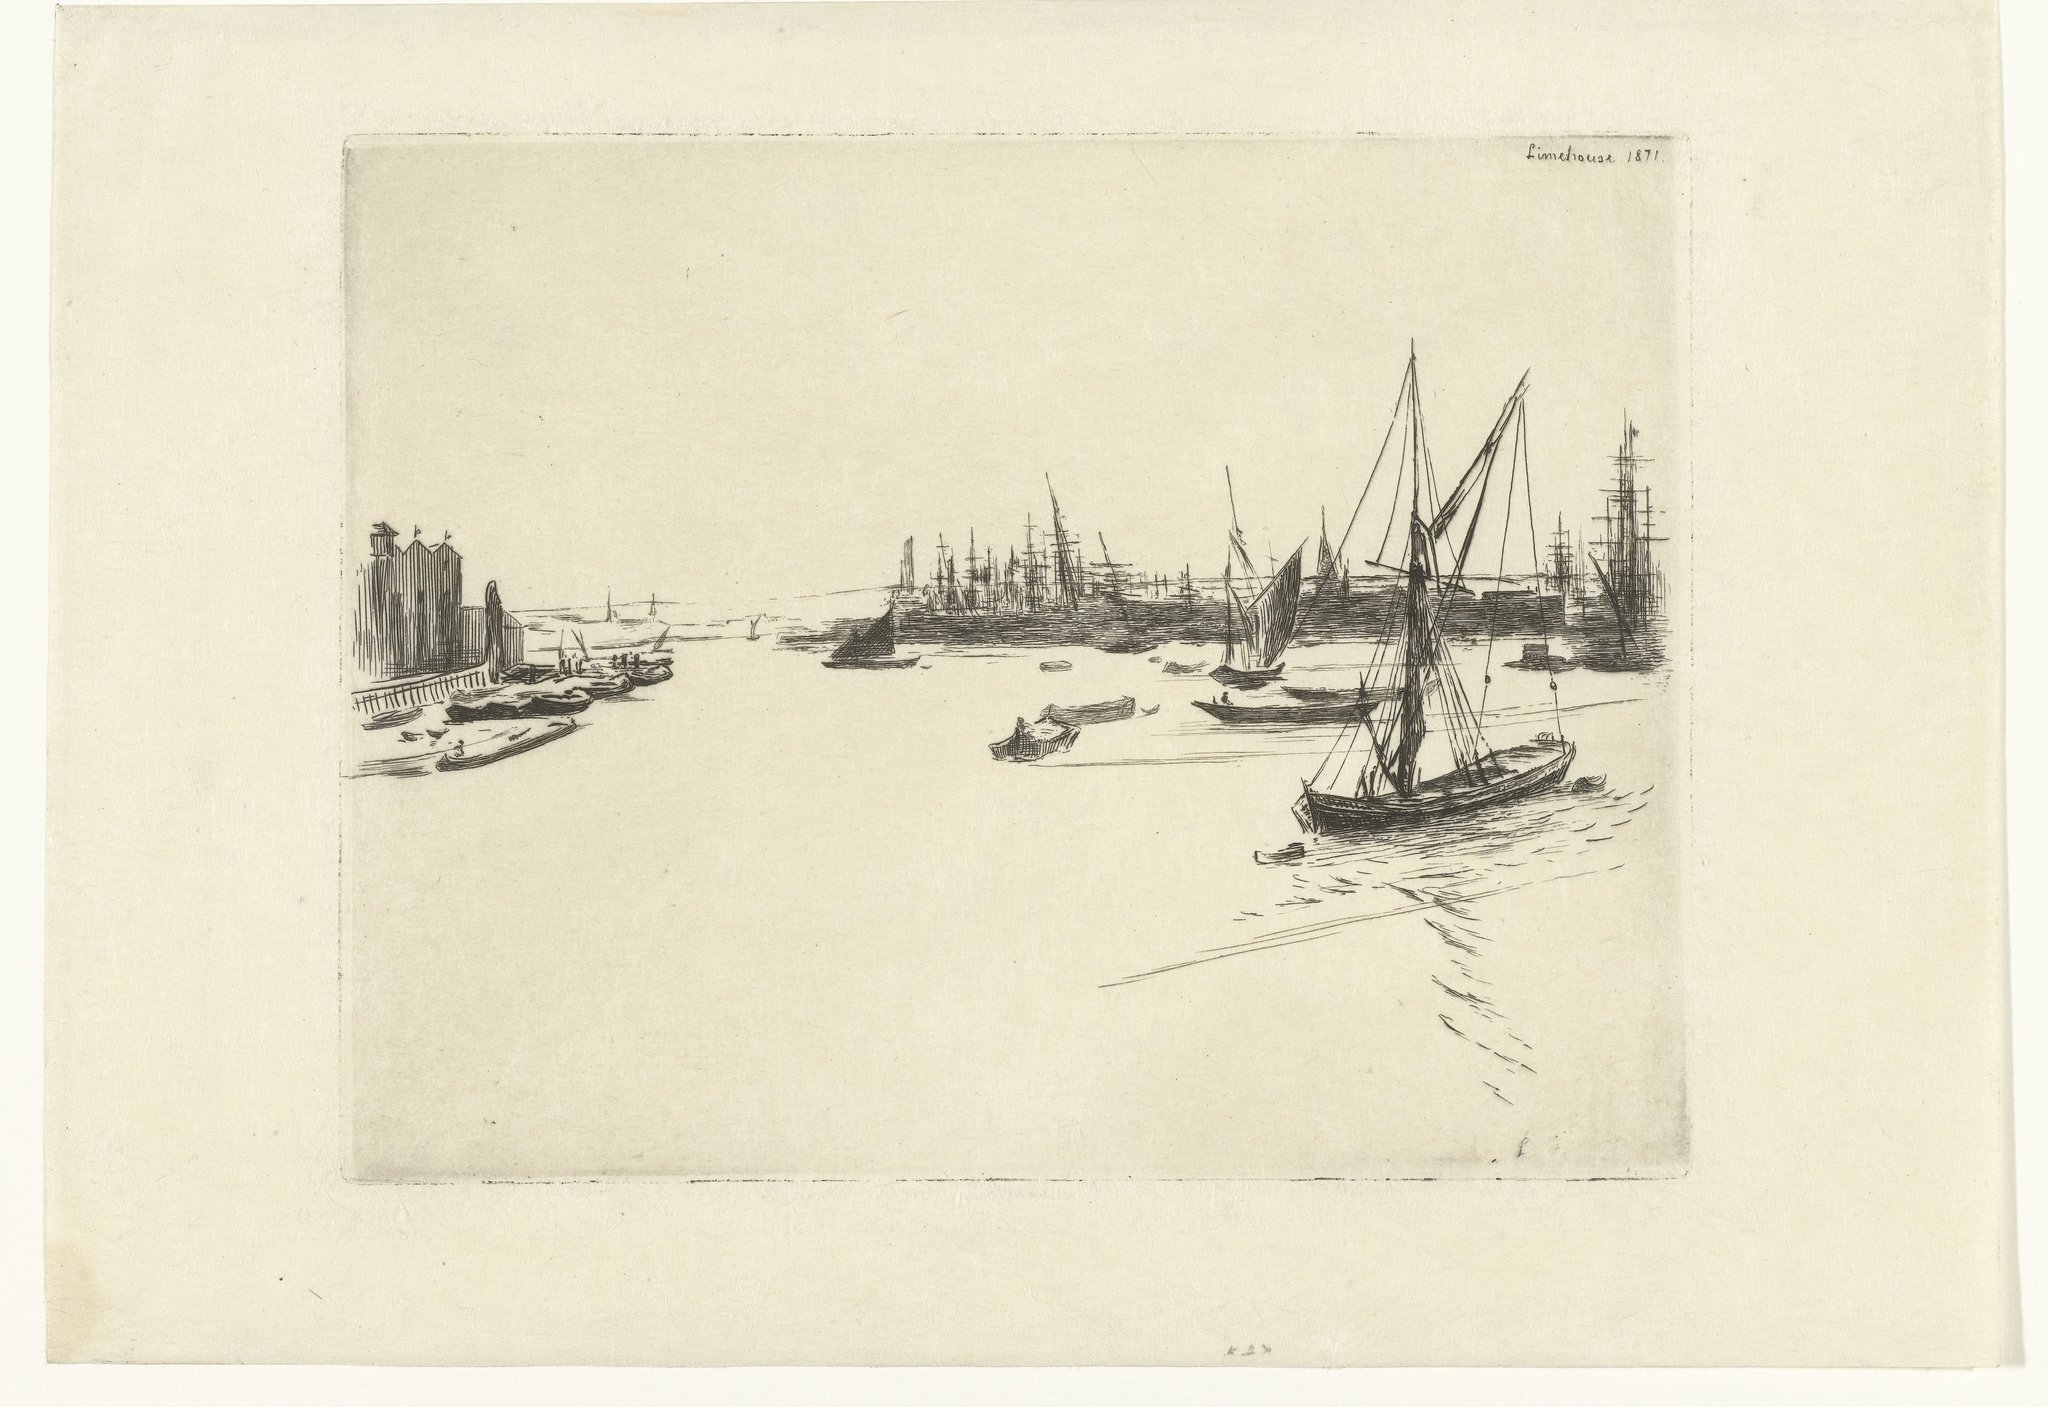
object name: print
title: Vue de la Tamise (prise de Limehouse)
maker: félix bracquemond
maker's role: print maker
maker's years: 1833-1914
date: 1871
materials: paper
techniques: etching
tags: harbour, river, thames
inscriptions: date